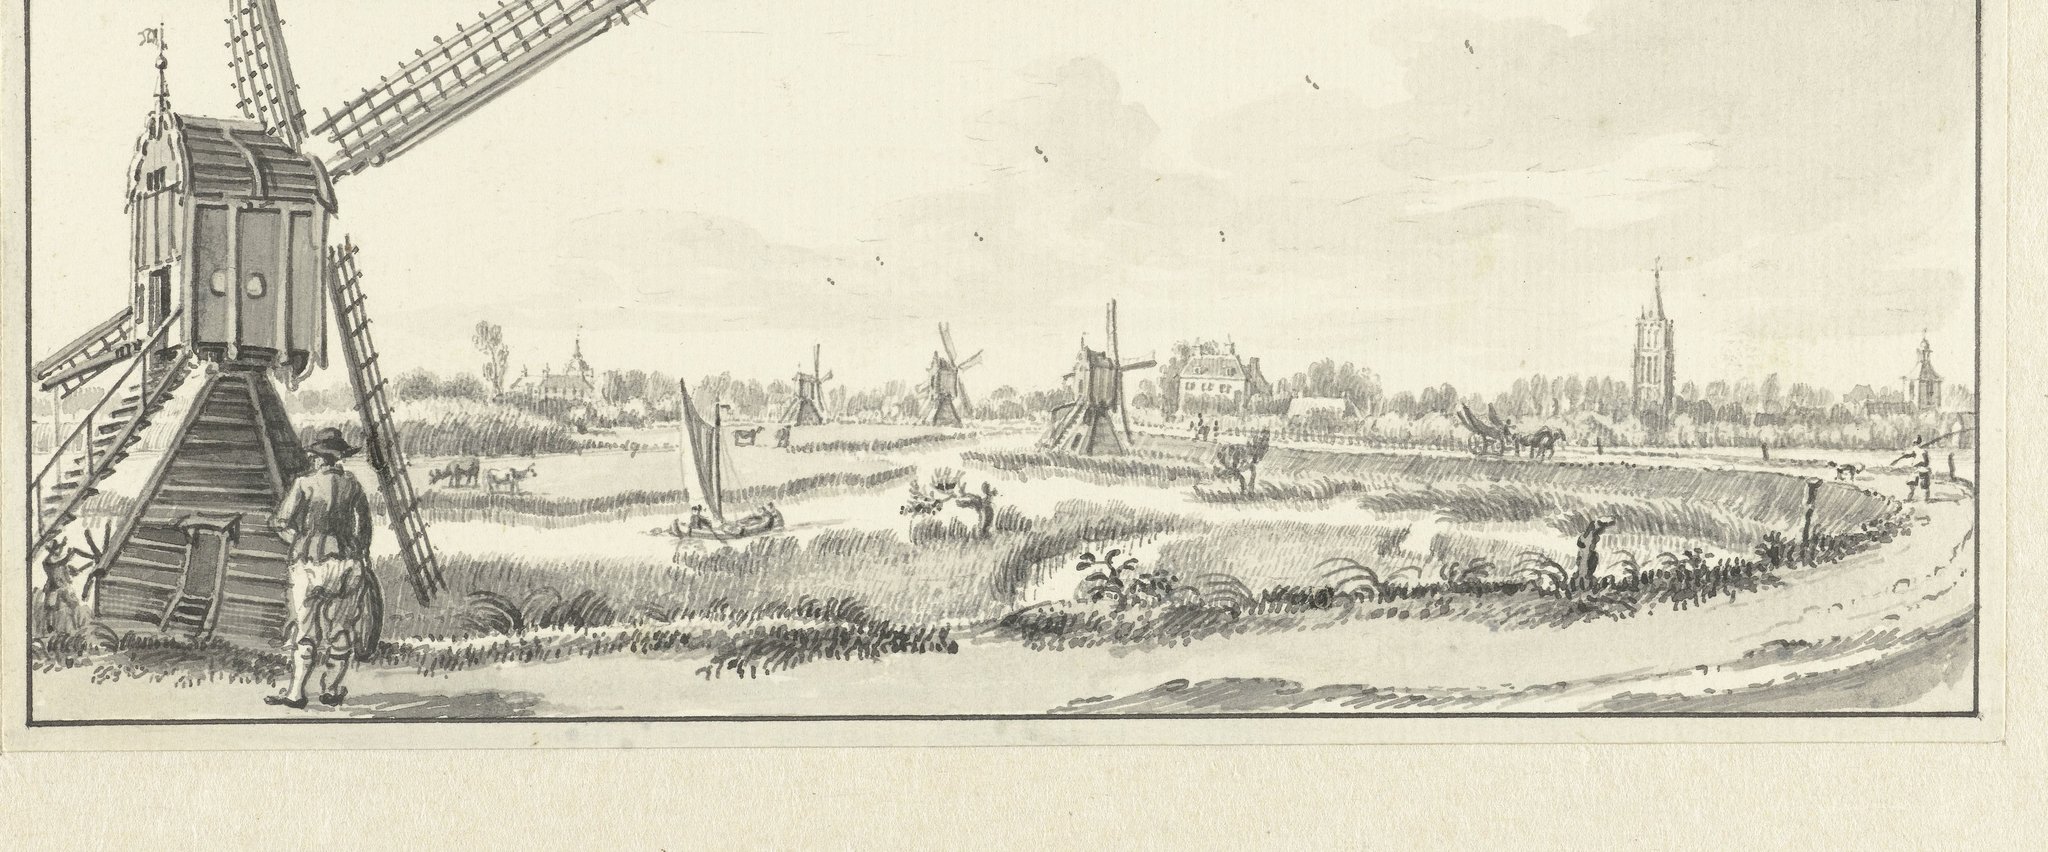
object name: drawing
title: Gezicht op Heukelum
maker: jan de beijer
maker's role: draughtsman, print maker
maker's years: 1703-1780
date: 1750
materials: ink, paper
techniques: brush, pen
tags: prospect of city, town panorama, silhouette of city